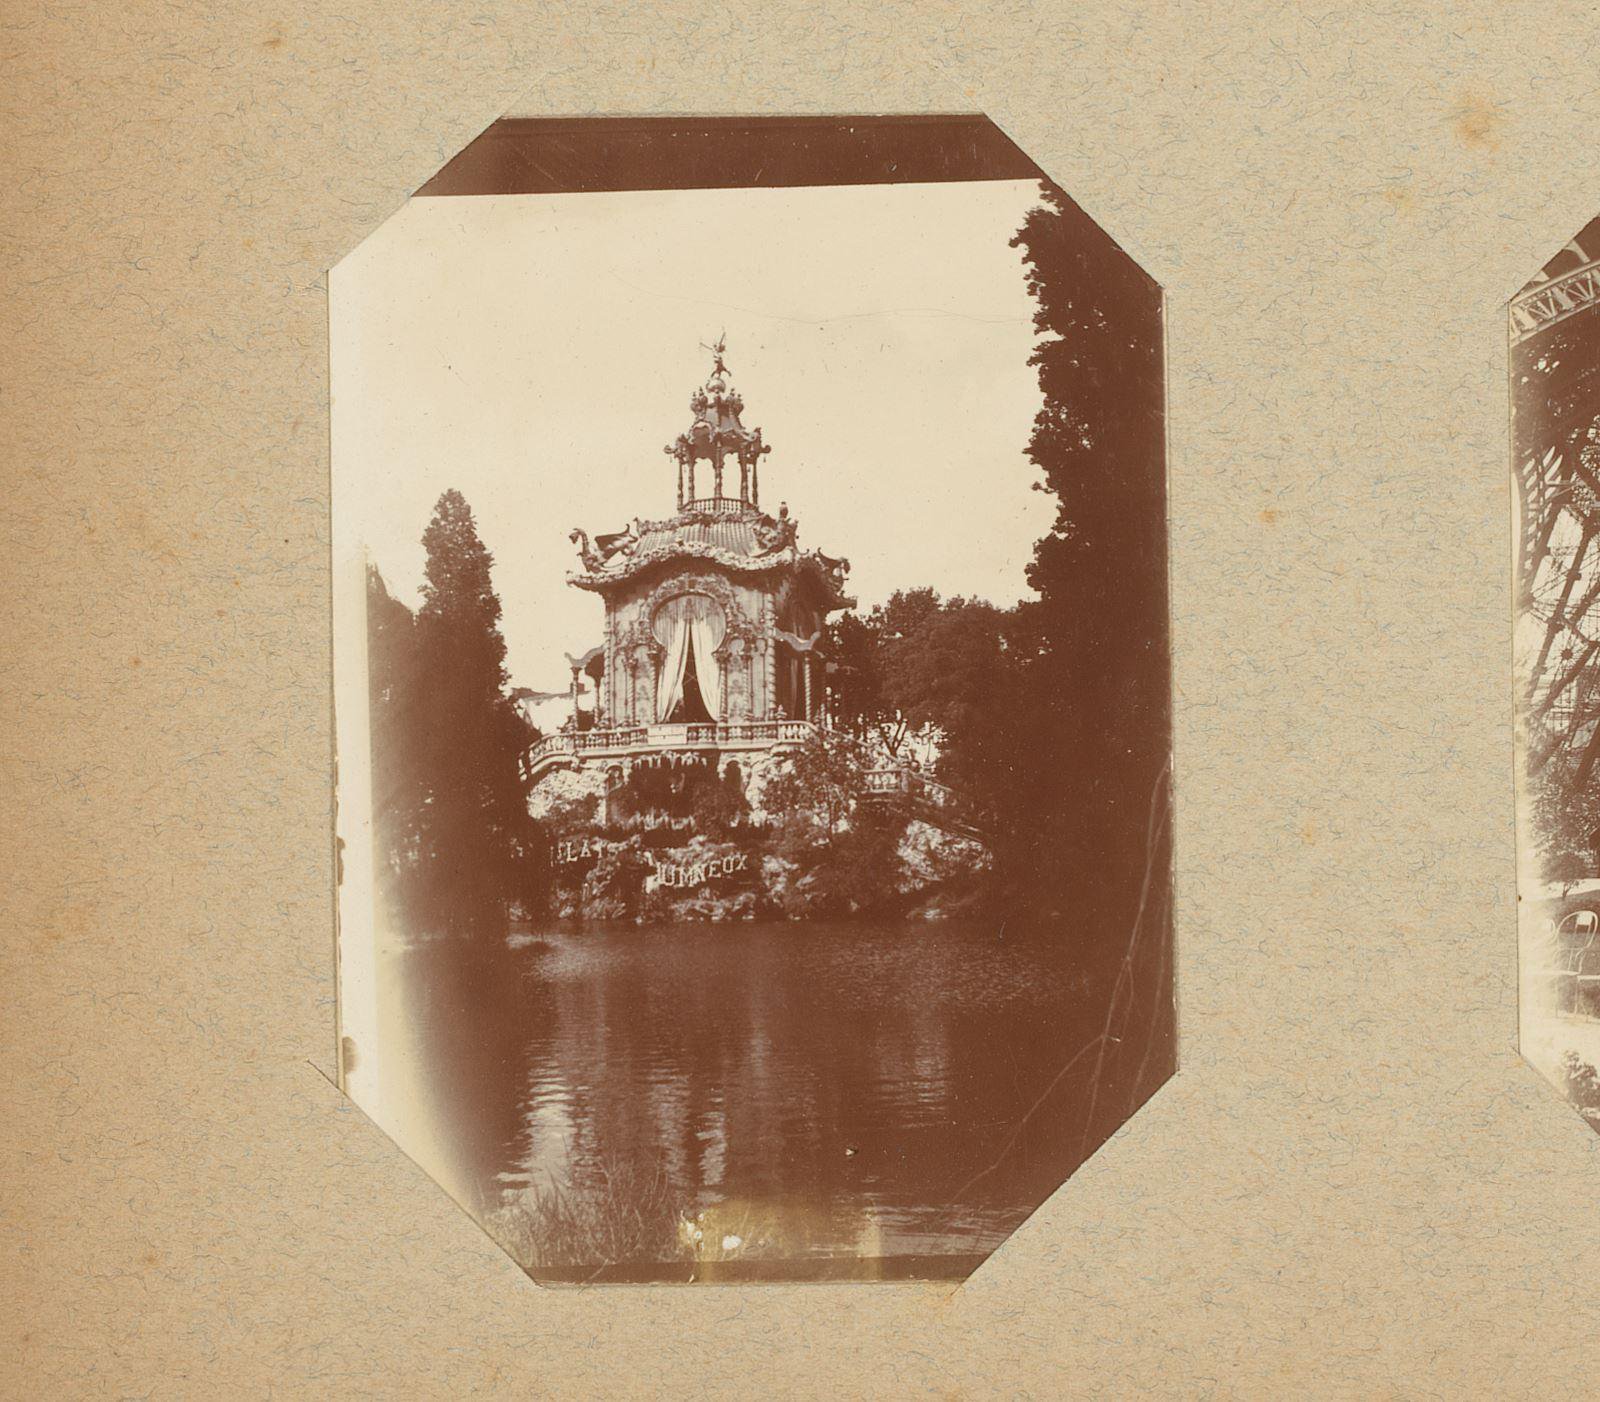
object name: album leaf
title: Palais Lumineux op de Wereldtentoonstelling van 1900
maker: Anonymous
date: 1900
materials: paper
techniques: gelatin silver print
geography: paris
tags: world fair, world exhibition, paris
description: Over de foto is een ander negatief afgedrukt van een voorstelling van bomen.